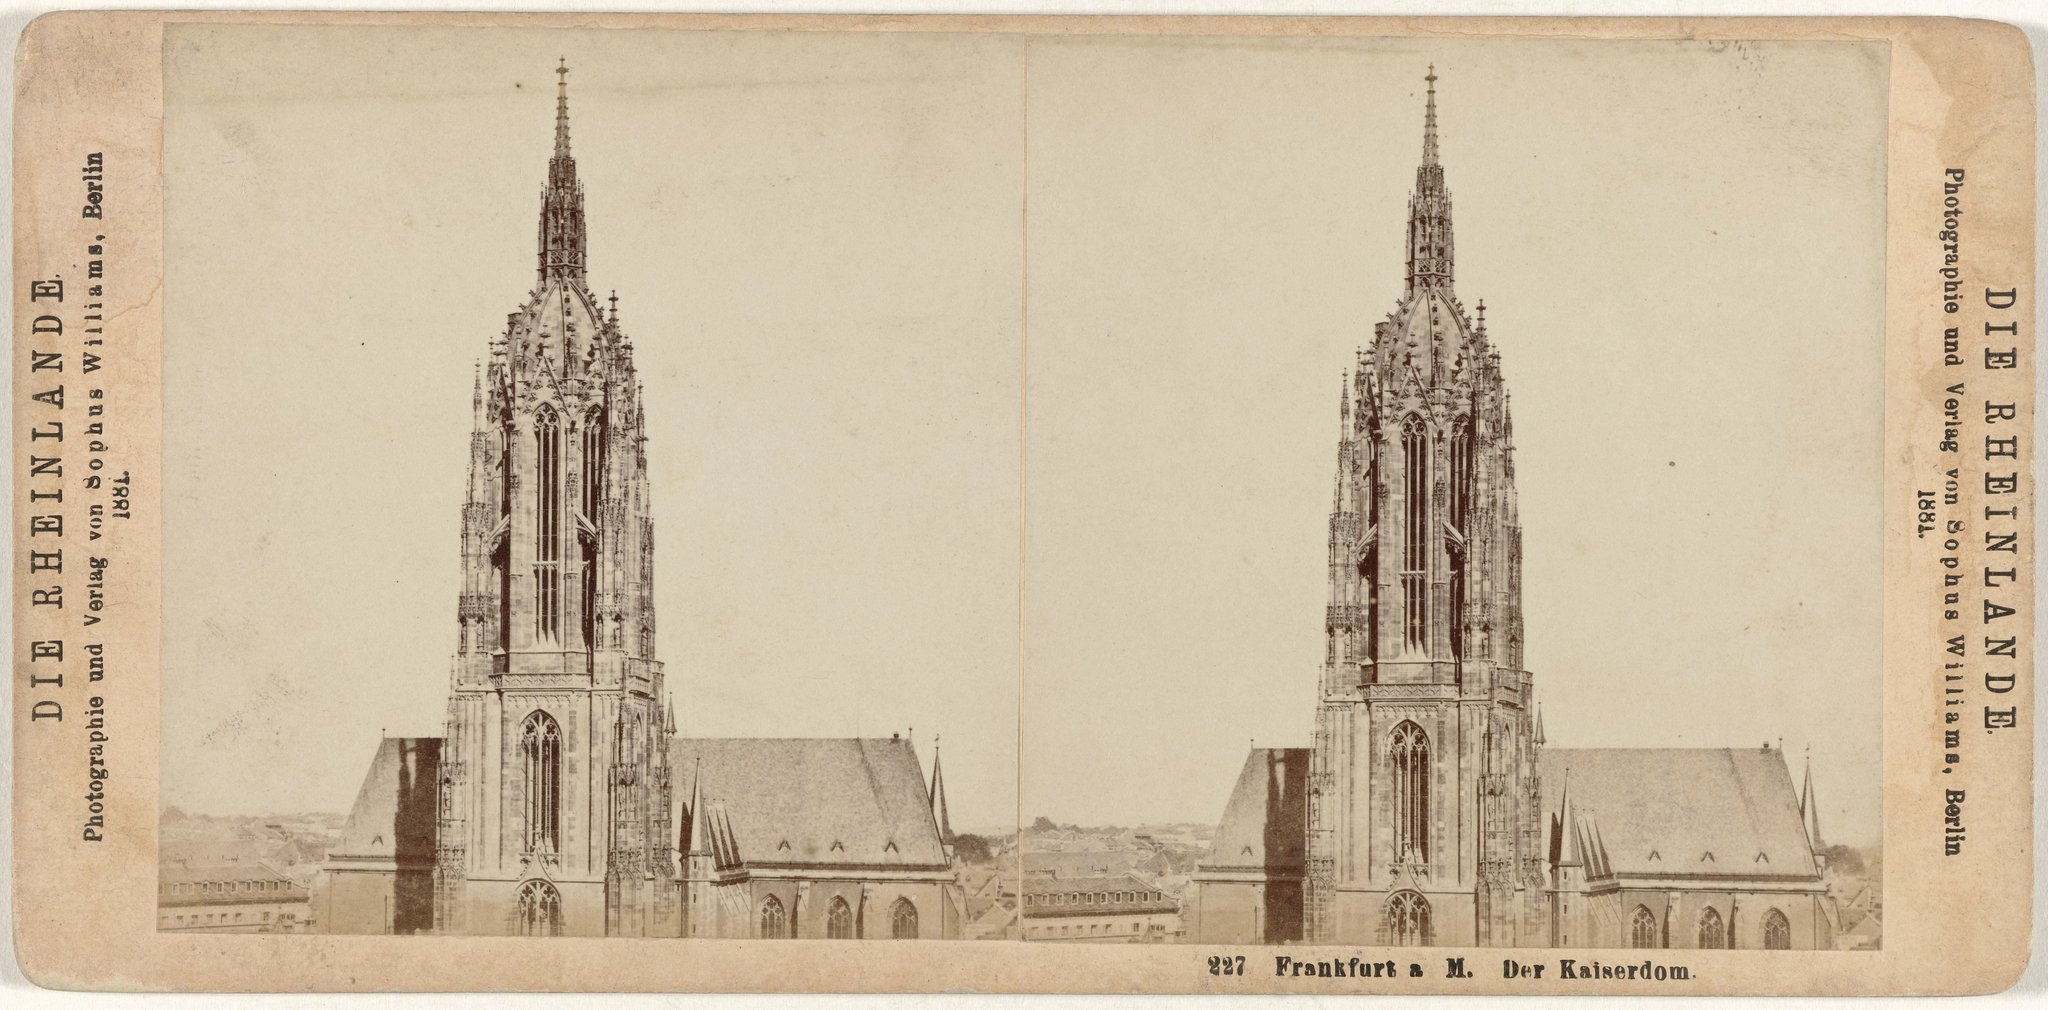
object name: stereograph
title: Die Rheinlande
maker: sophus williams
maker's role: publisher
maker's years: 1835-1900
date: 1881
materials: cardboard, paper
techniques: albumen print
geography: frankfurt am main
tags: parts of church exterior and annexes: tower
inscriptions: number: ‘227’